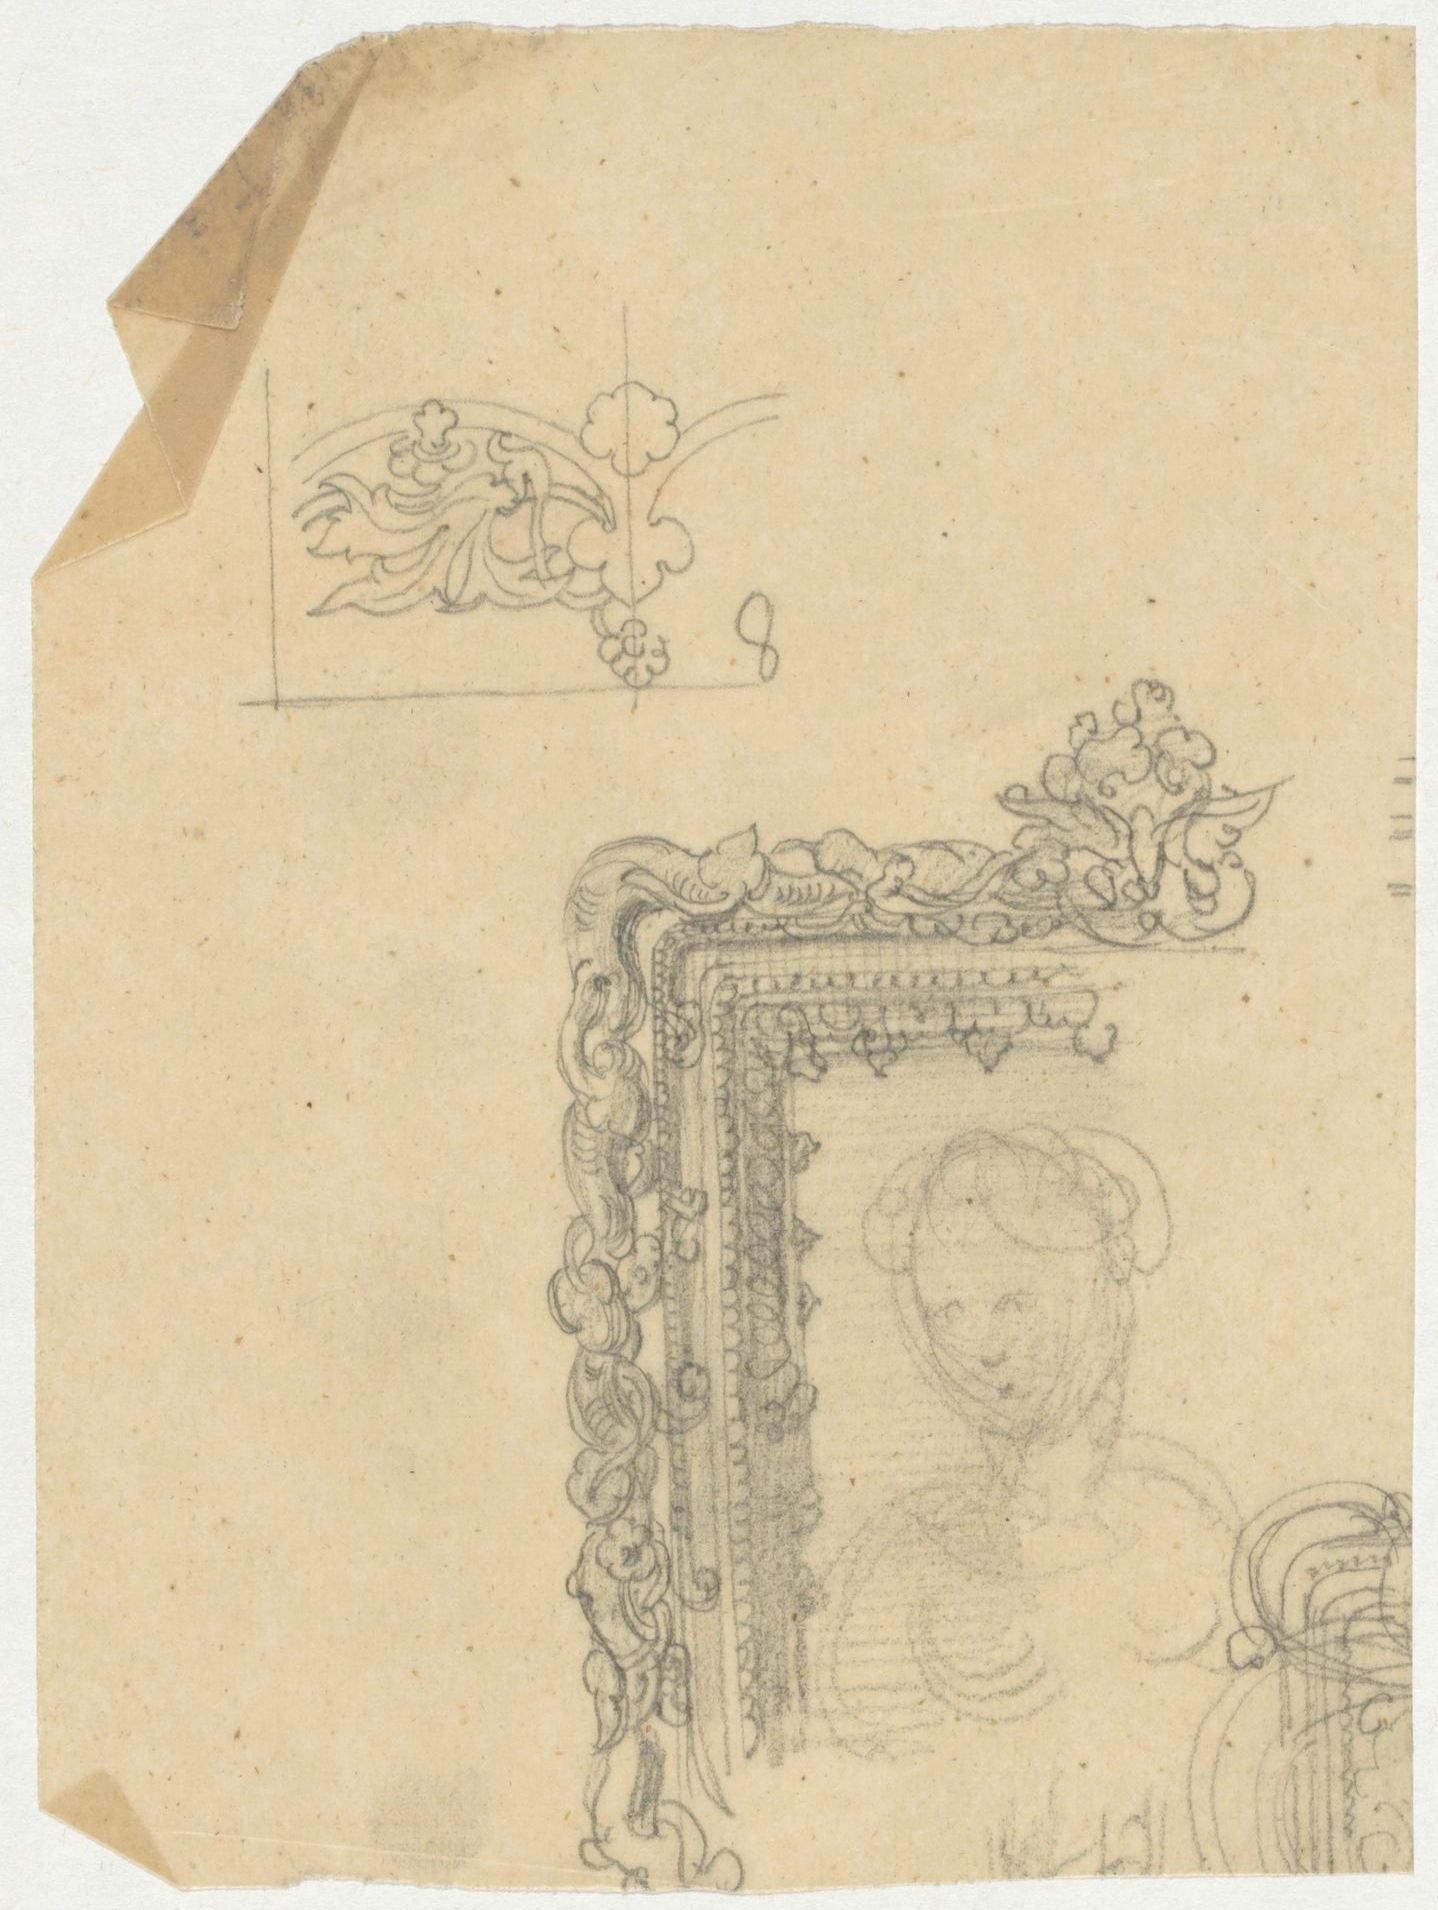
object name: design drawing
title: Deel van een lijst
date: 1830-1850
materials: graphite, paper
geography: paris